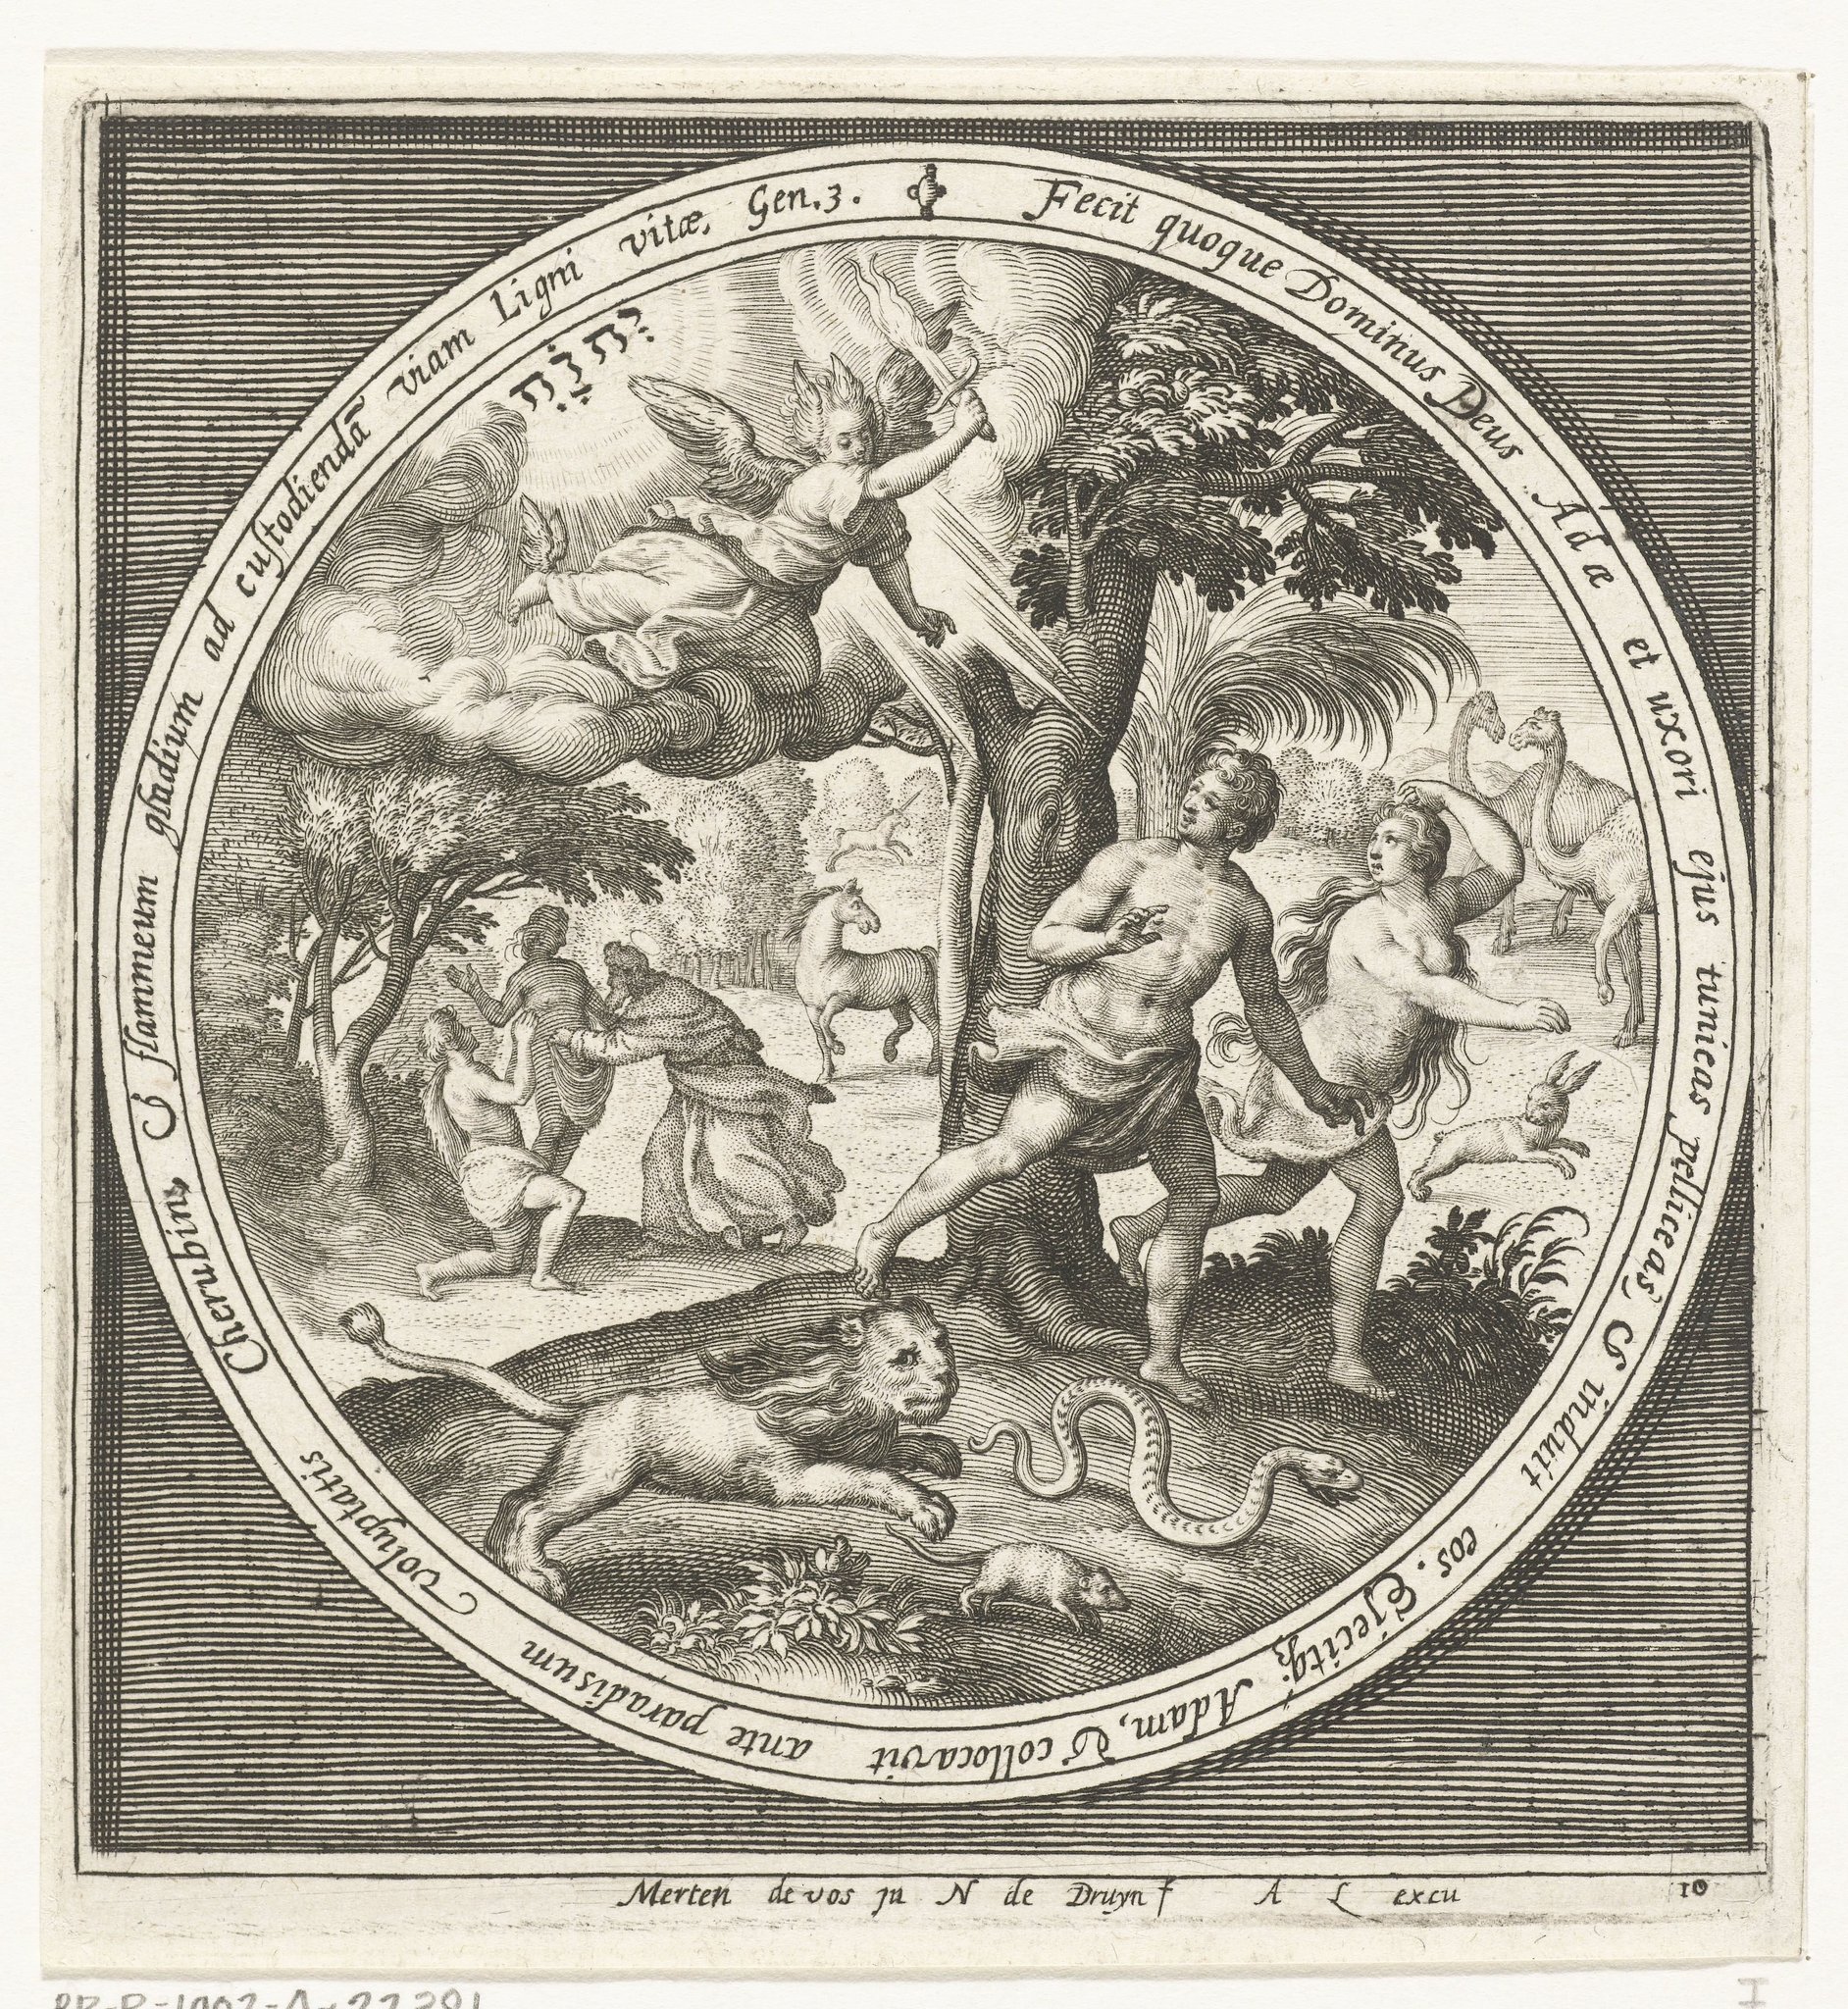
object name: print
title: Expulsion from Paradise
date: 1581-1656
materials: paper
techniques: engraving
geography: netherlands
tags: god expels adam and eve from paradise and has the tree of life guarded by an angel with a flaming sword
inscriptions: collector's mark: Lugt 2542, collector's mark: Lugt 2228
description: Adam en Eva worden door engel met vlammend zwaard weggejaagd uit het paradijs. In medaillon met als opschrift een bijbeltekst in Latijn uit Genesis 3, binnen rechthoekige omlijsting.